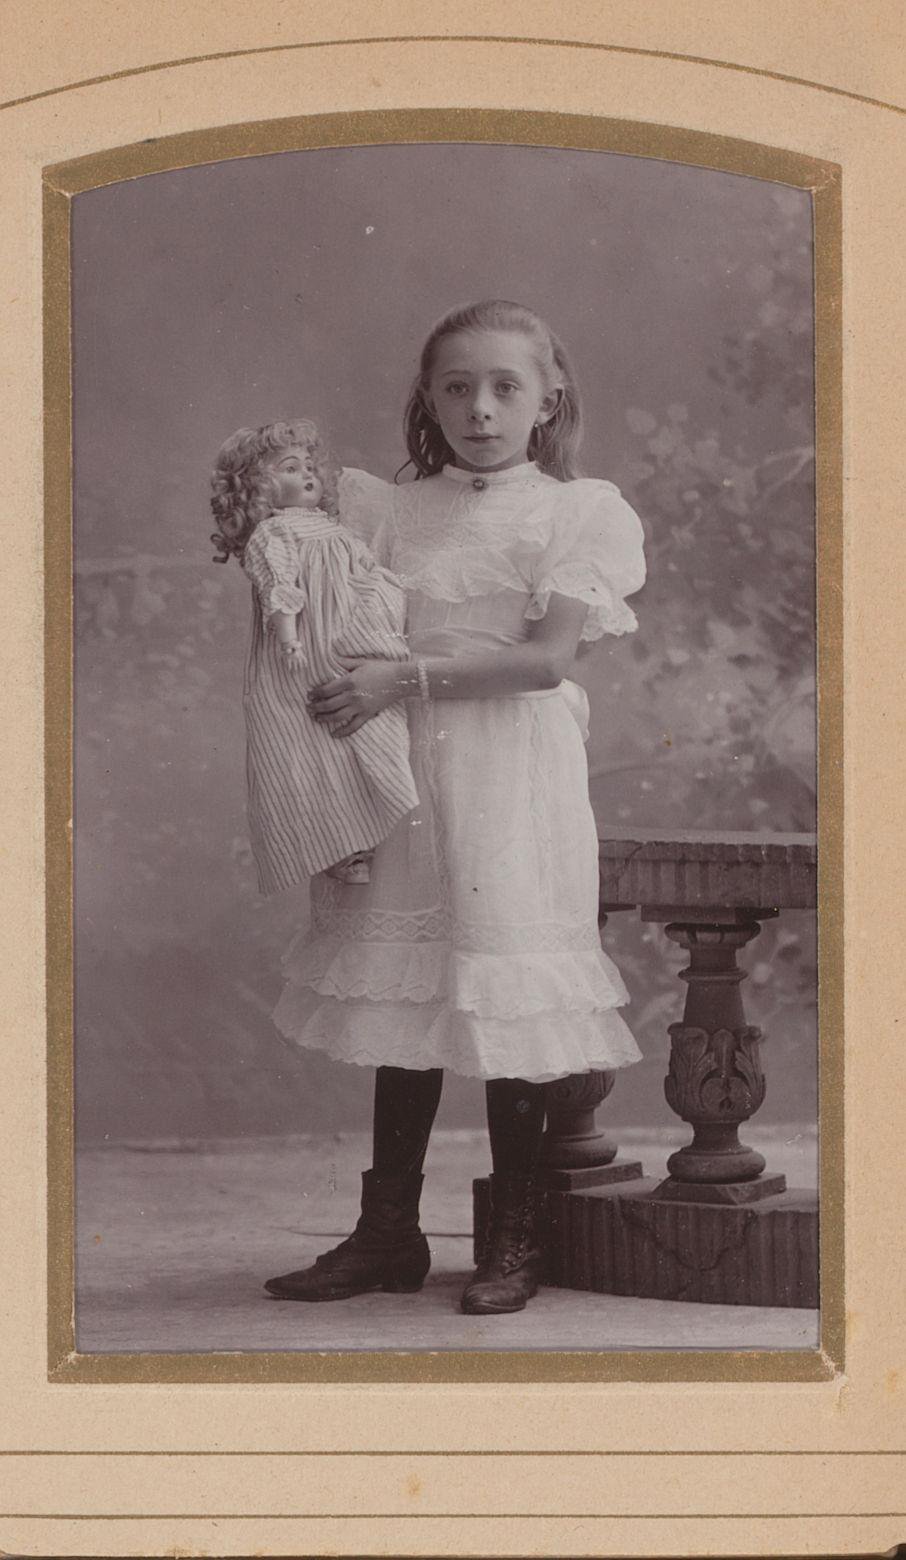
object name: album leaf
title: Portret van een staand meisje met pop in de hand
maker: machiel hendricus laddé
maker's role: fotograaf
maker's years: 1866-1932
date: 1892-1906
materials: cardboard, photographic support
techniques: collodion silver print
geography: amsterdam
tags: historical persons - bb - woman, girl (child between toddler and youth), (playing with) dolls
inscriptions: inscription: ‘Fotografie/ Artistique/ M. H. Laddé/ Amsterdam/ Nieuwendijk 57-59/ boven de Firma MERKELBACH & Co/ Het Cliché wordt voor verdere bestellingen bewaard.’